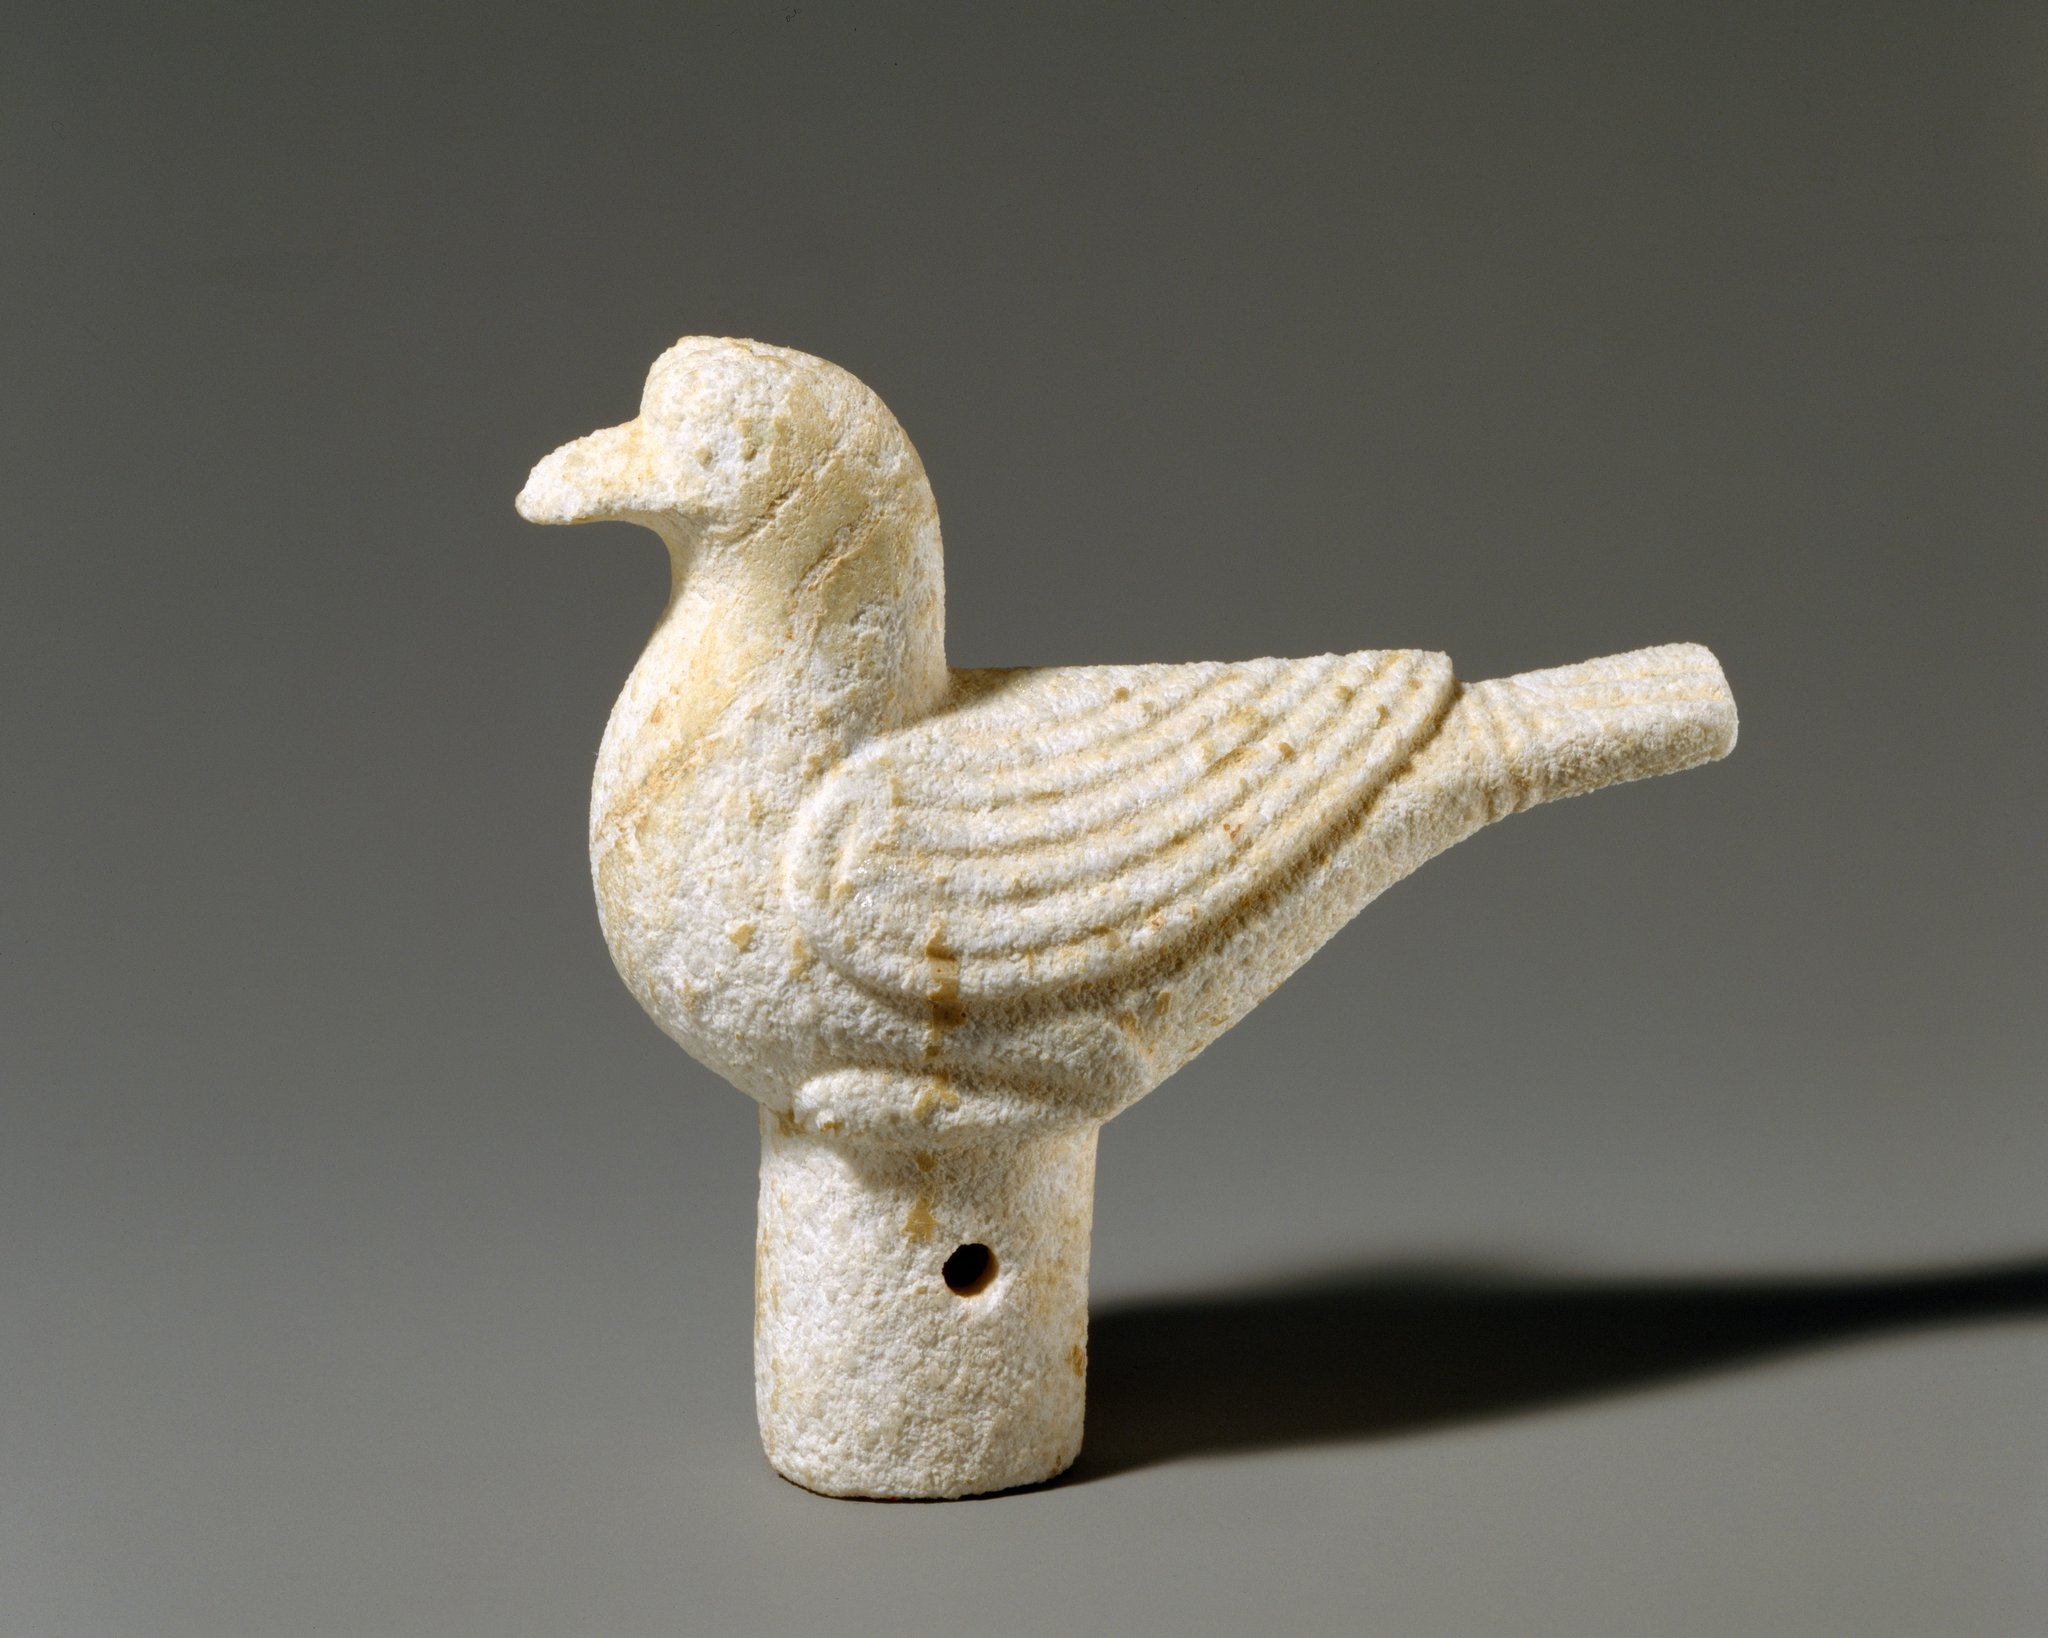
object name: finial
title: Bird-Shaped finial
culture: chinese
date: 25-220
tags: birds